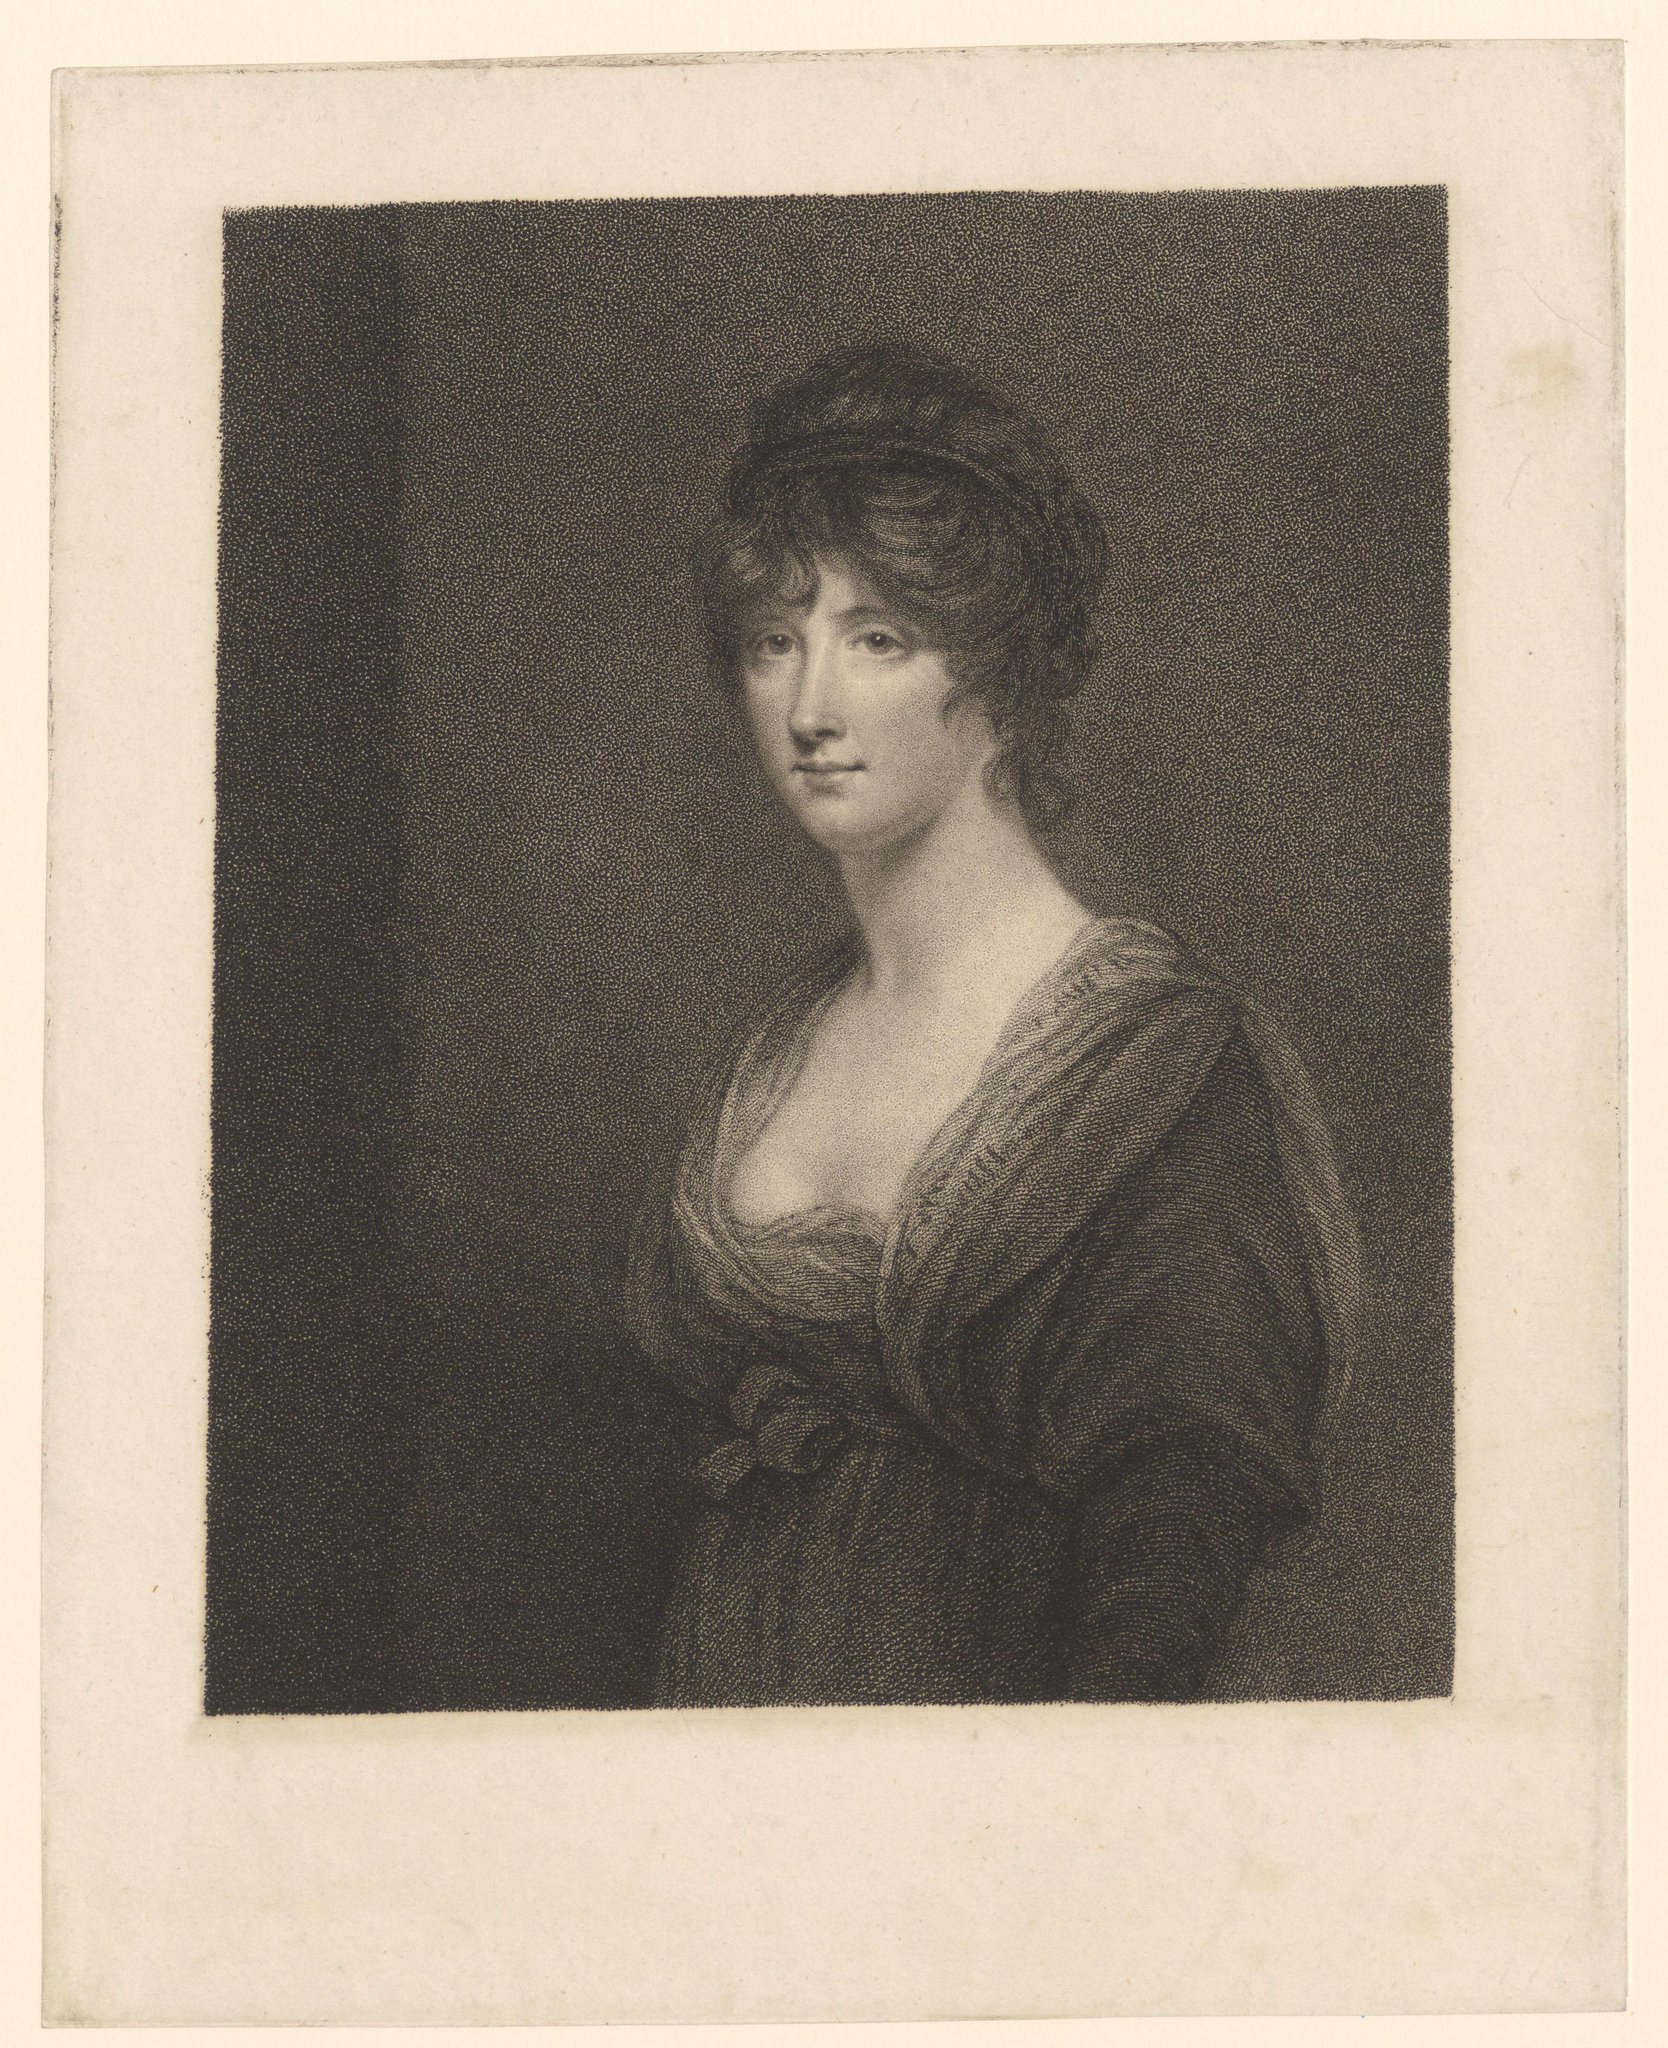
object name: print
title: Portret van een onbekende vrouw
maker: Anonymous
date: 1750-1850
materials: paper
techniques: etching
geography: england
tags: historical persons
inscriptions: collector's mark: Lugt 5g, collector's mark: Lugt 2228